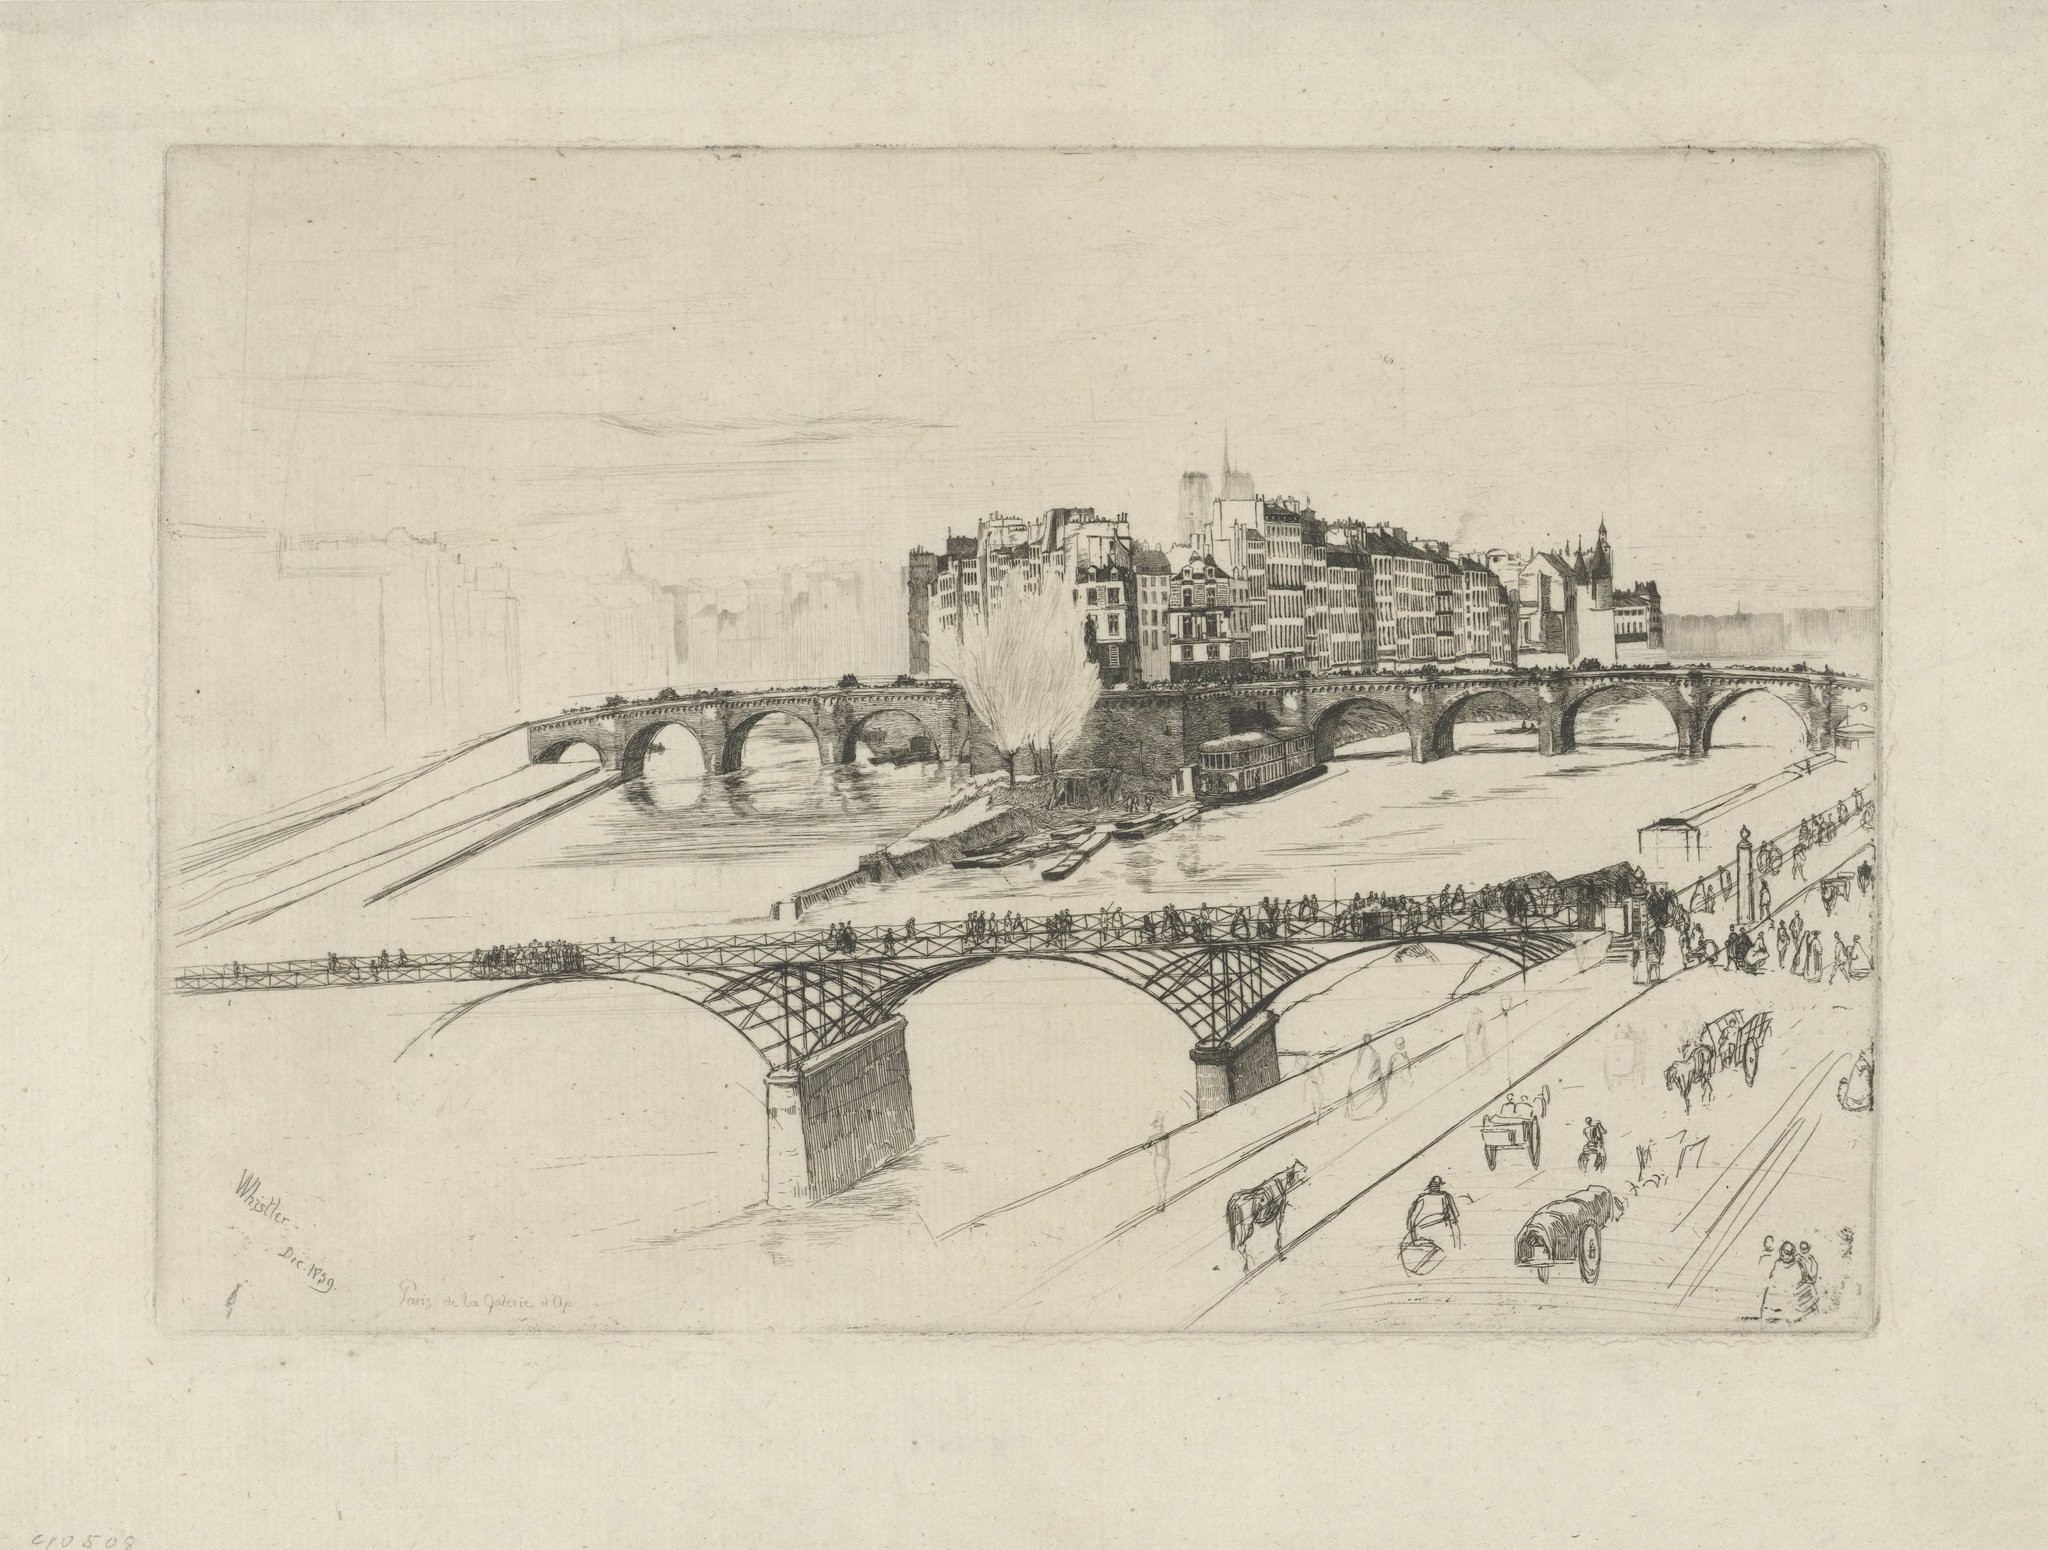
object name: print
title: Île de la Cité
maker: james abbott mcneill whistler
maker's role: painter, print maker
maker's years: 1834-1903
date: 1812-1859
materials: paper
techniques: etching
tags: city-view in general; 'veduta'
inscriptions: inscription: ‘Paris de la Galerie d'ap’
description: Gezicht op de Seine en het île de la cité in Parijs.